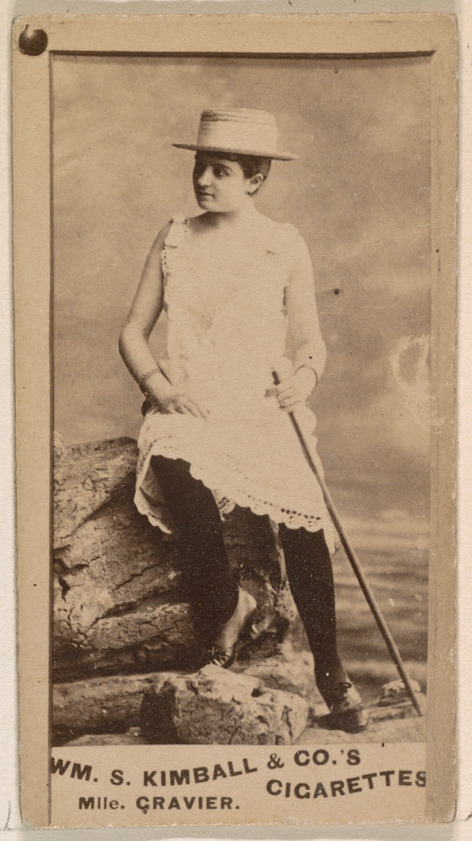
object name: photograph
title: Mlle Gravier, from the Actresses series (N203) issued by Wm. S. Kimball & Co.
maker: william s. kimball & company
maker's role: publisher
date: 1889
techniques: color lithograph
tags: portraits,women,actresses